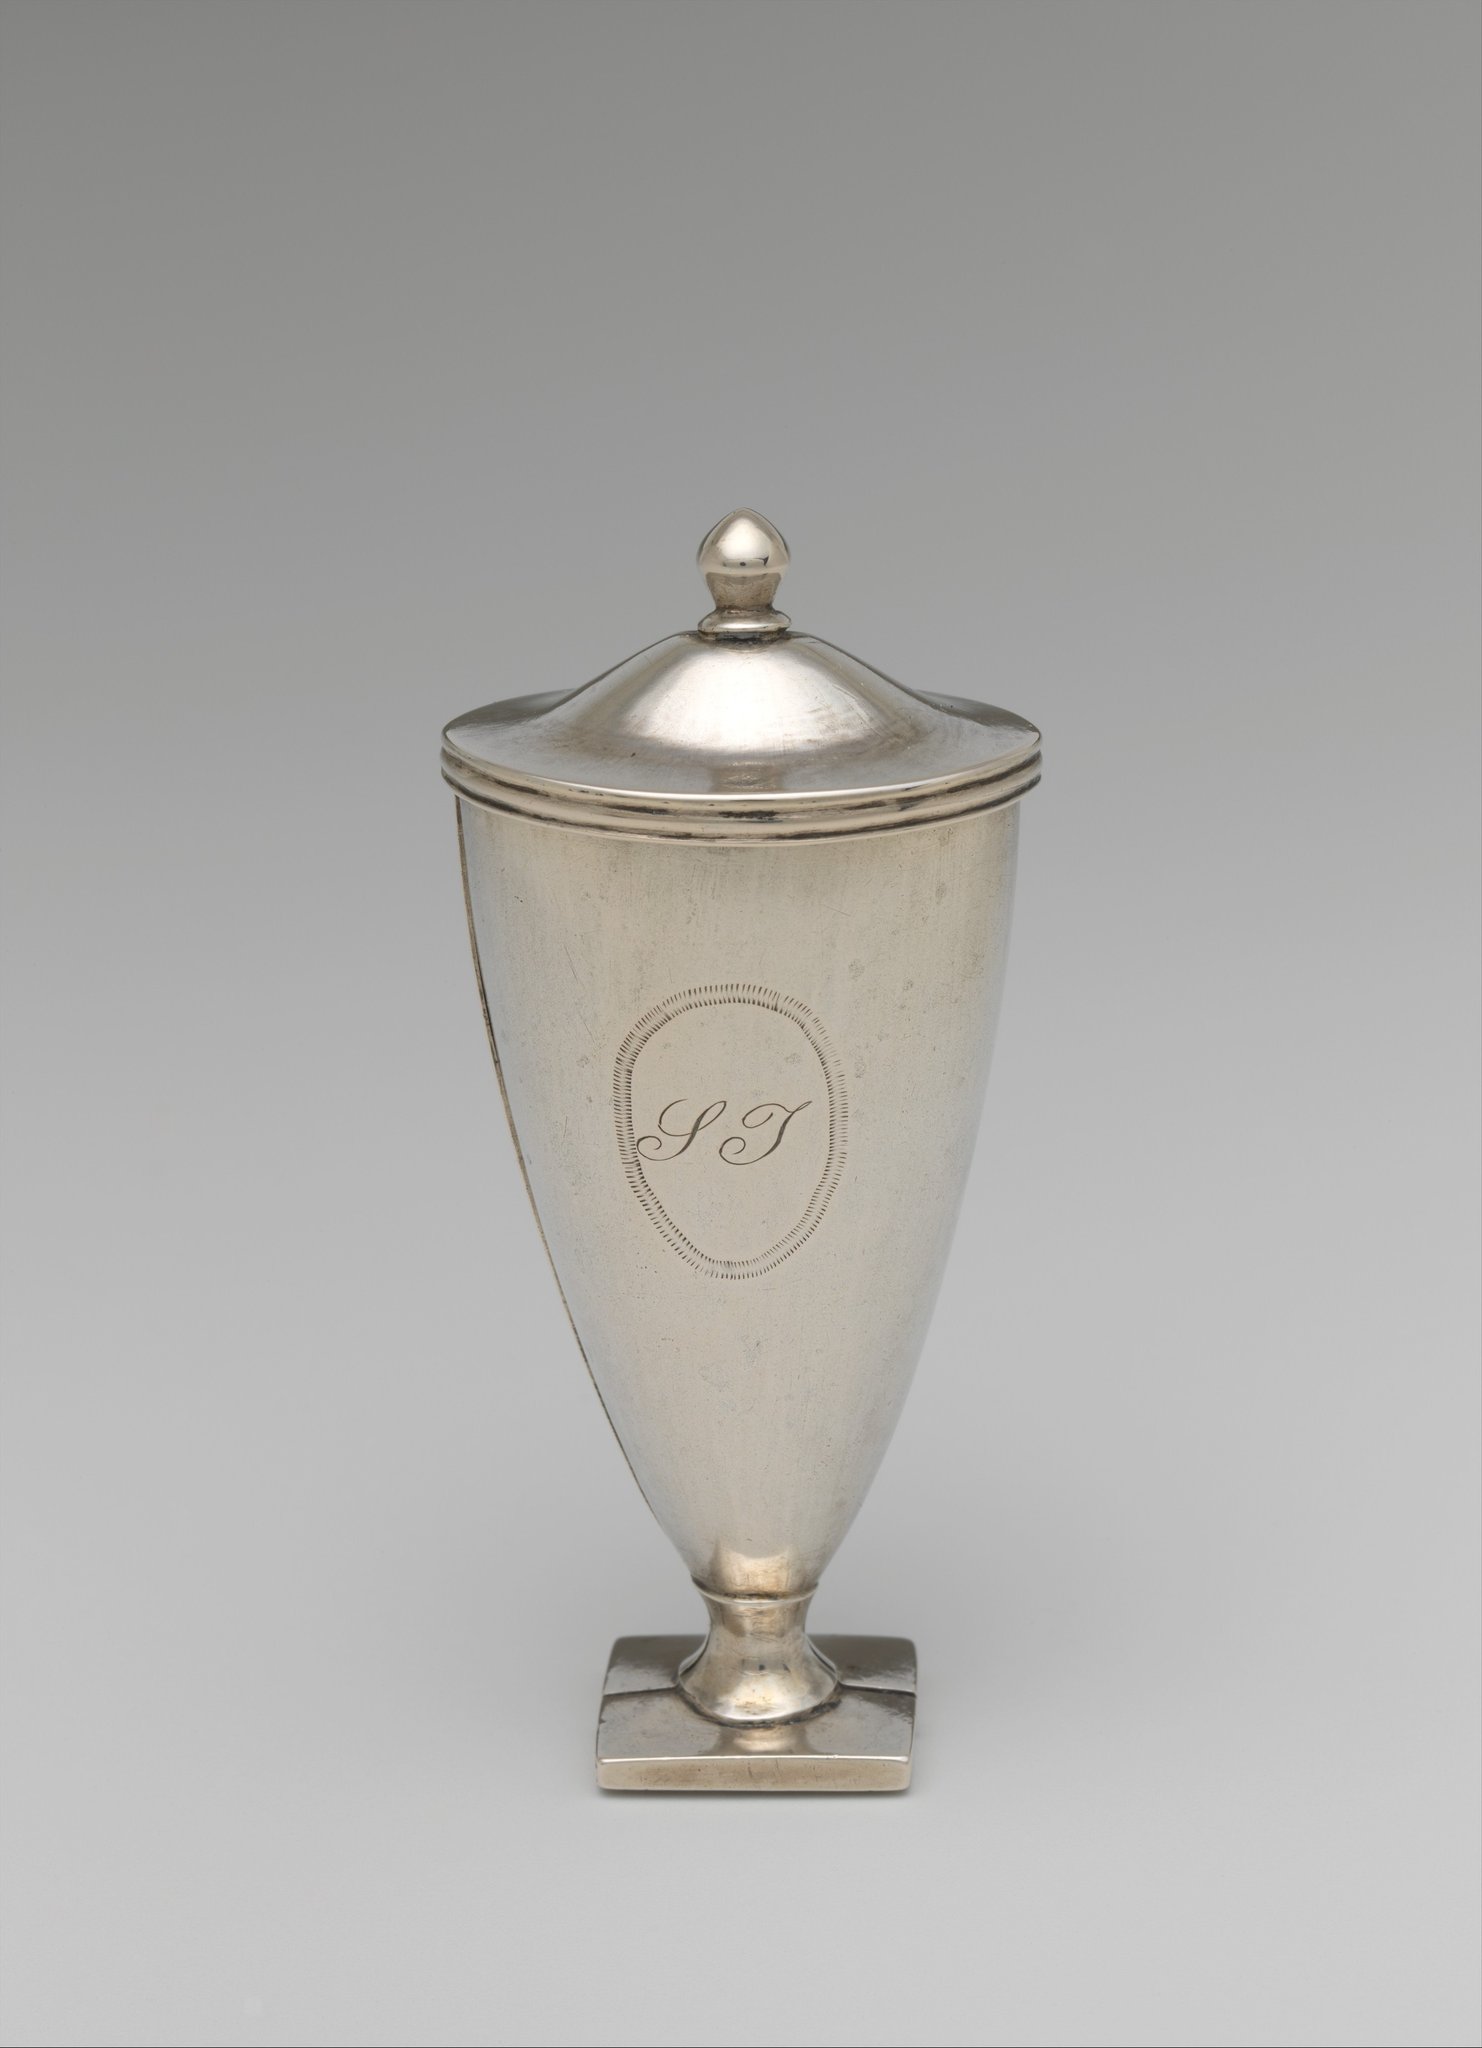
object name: nutmeg grater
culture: american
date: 1775-1800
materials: silver, steel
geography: united states